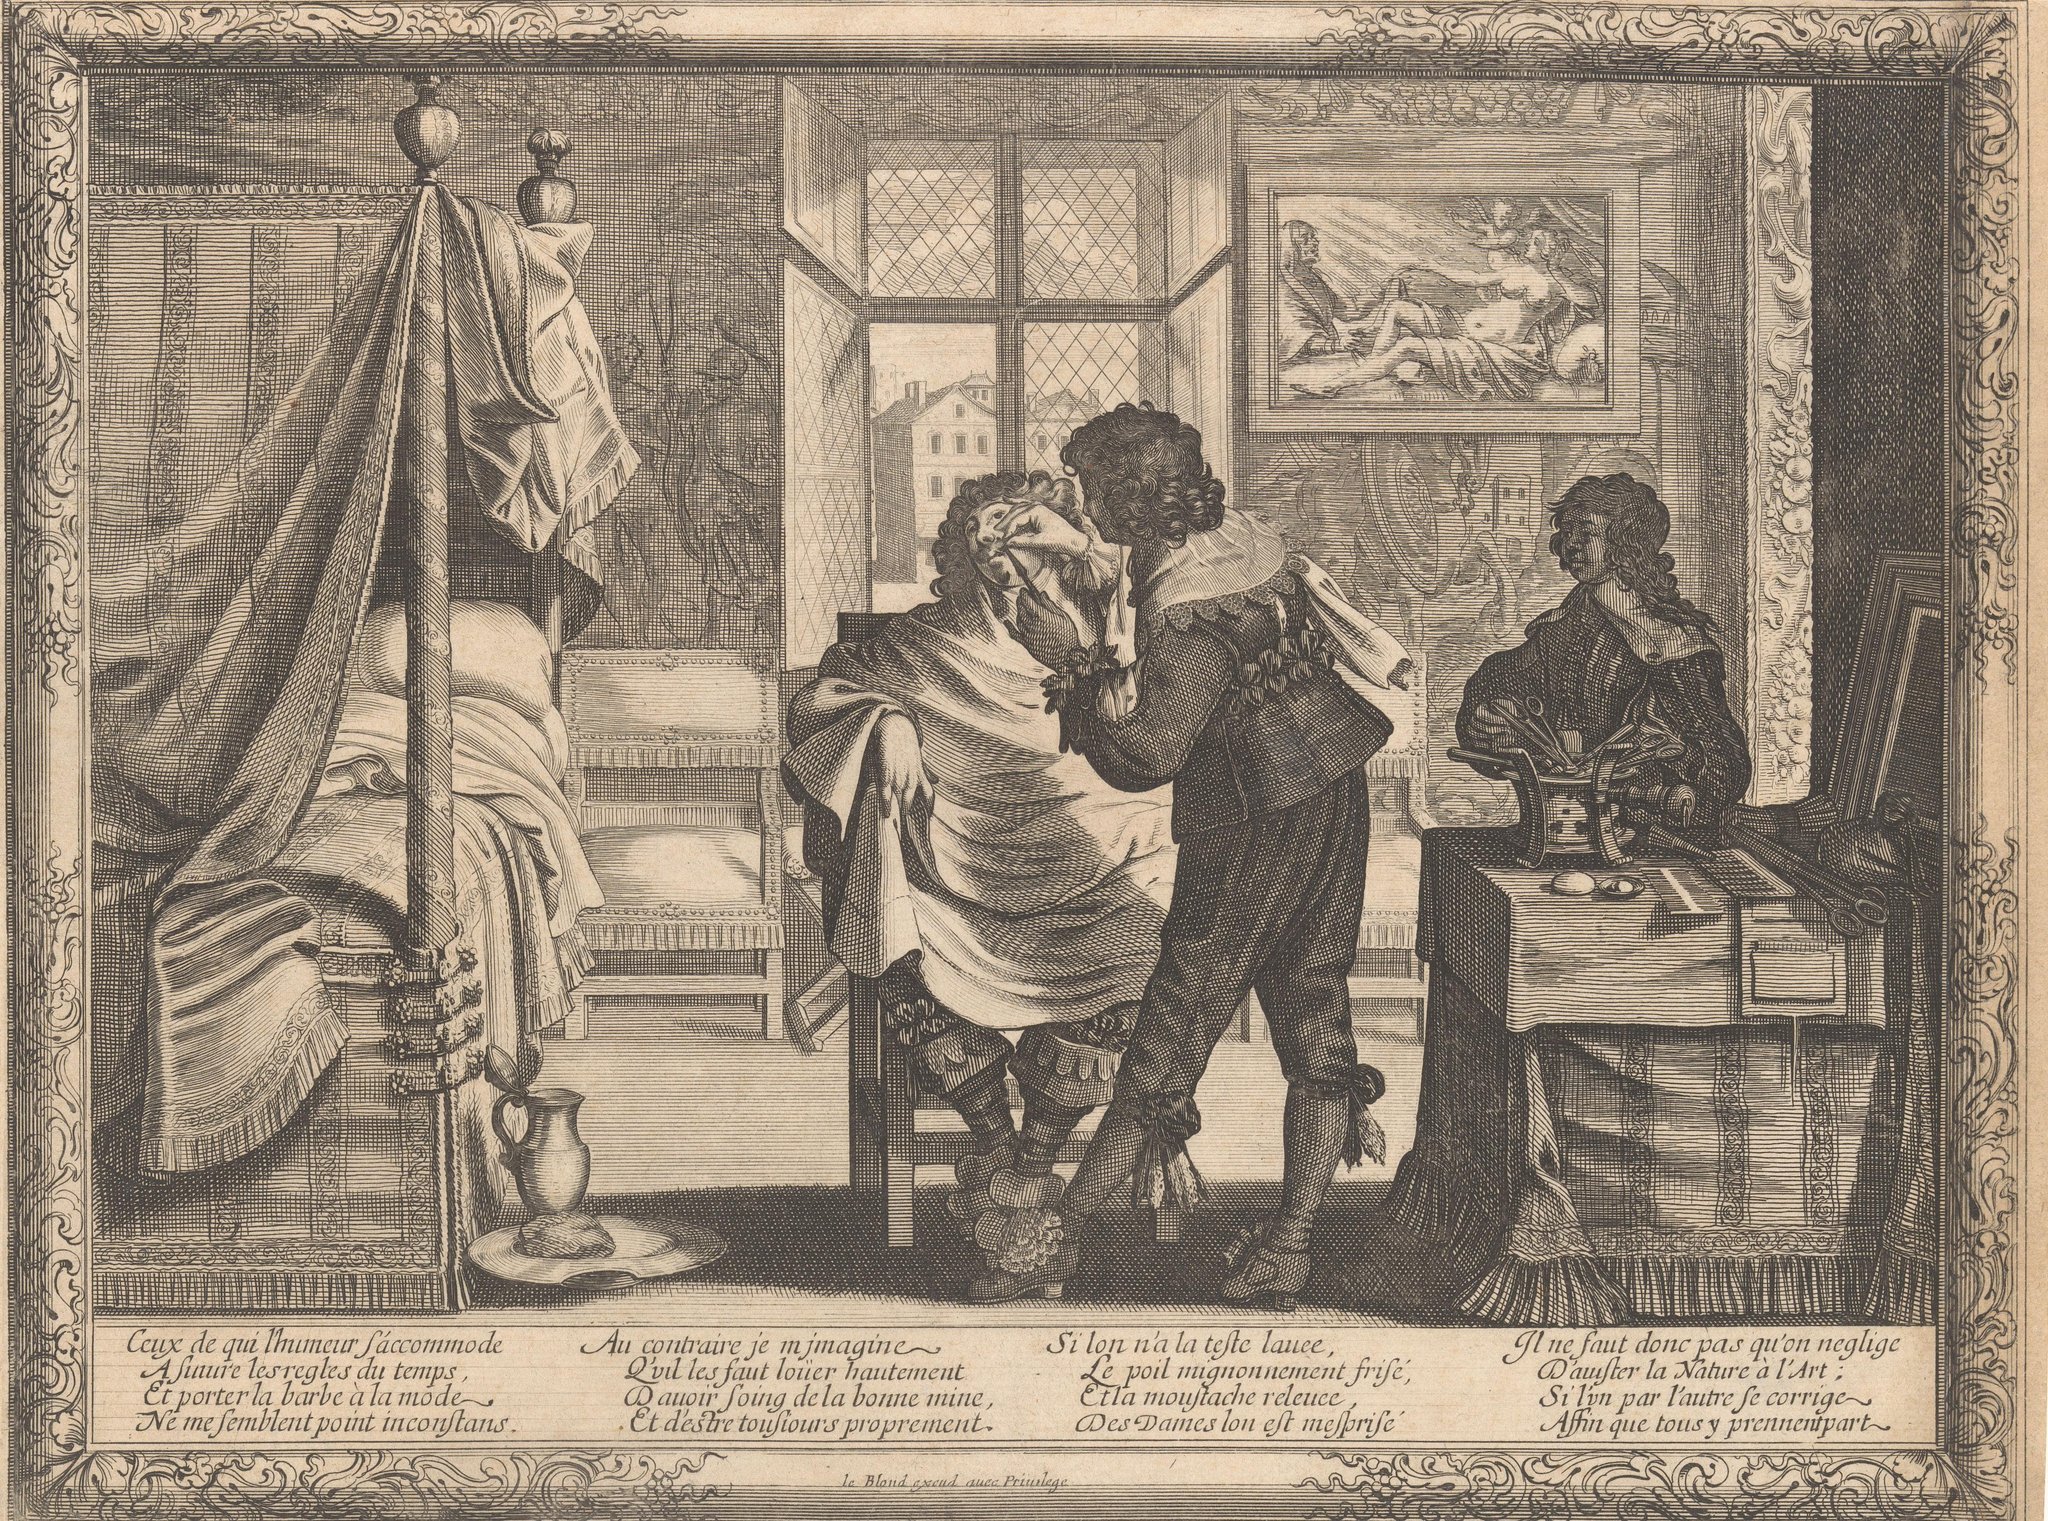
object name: print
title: Barbier werkt de snor van een man bij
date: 1632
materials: paper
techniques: engraving, etching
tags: making toilet, bed with tester, moustache, barber, barbershop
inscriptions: collector's mark: Lugt 2228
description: In een slaapvertrek met links een beslapen hemelbed friseert een barbier de snor van een man met behulp van een ijzer. De man zit met een laken om op een stoel. Rechts staat een lakei bij een tafel waarop scharen, kammen en ander kappersgerei. Aan de muren gobelins en een schilderij van Zeus en Danae.